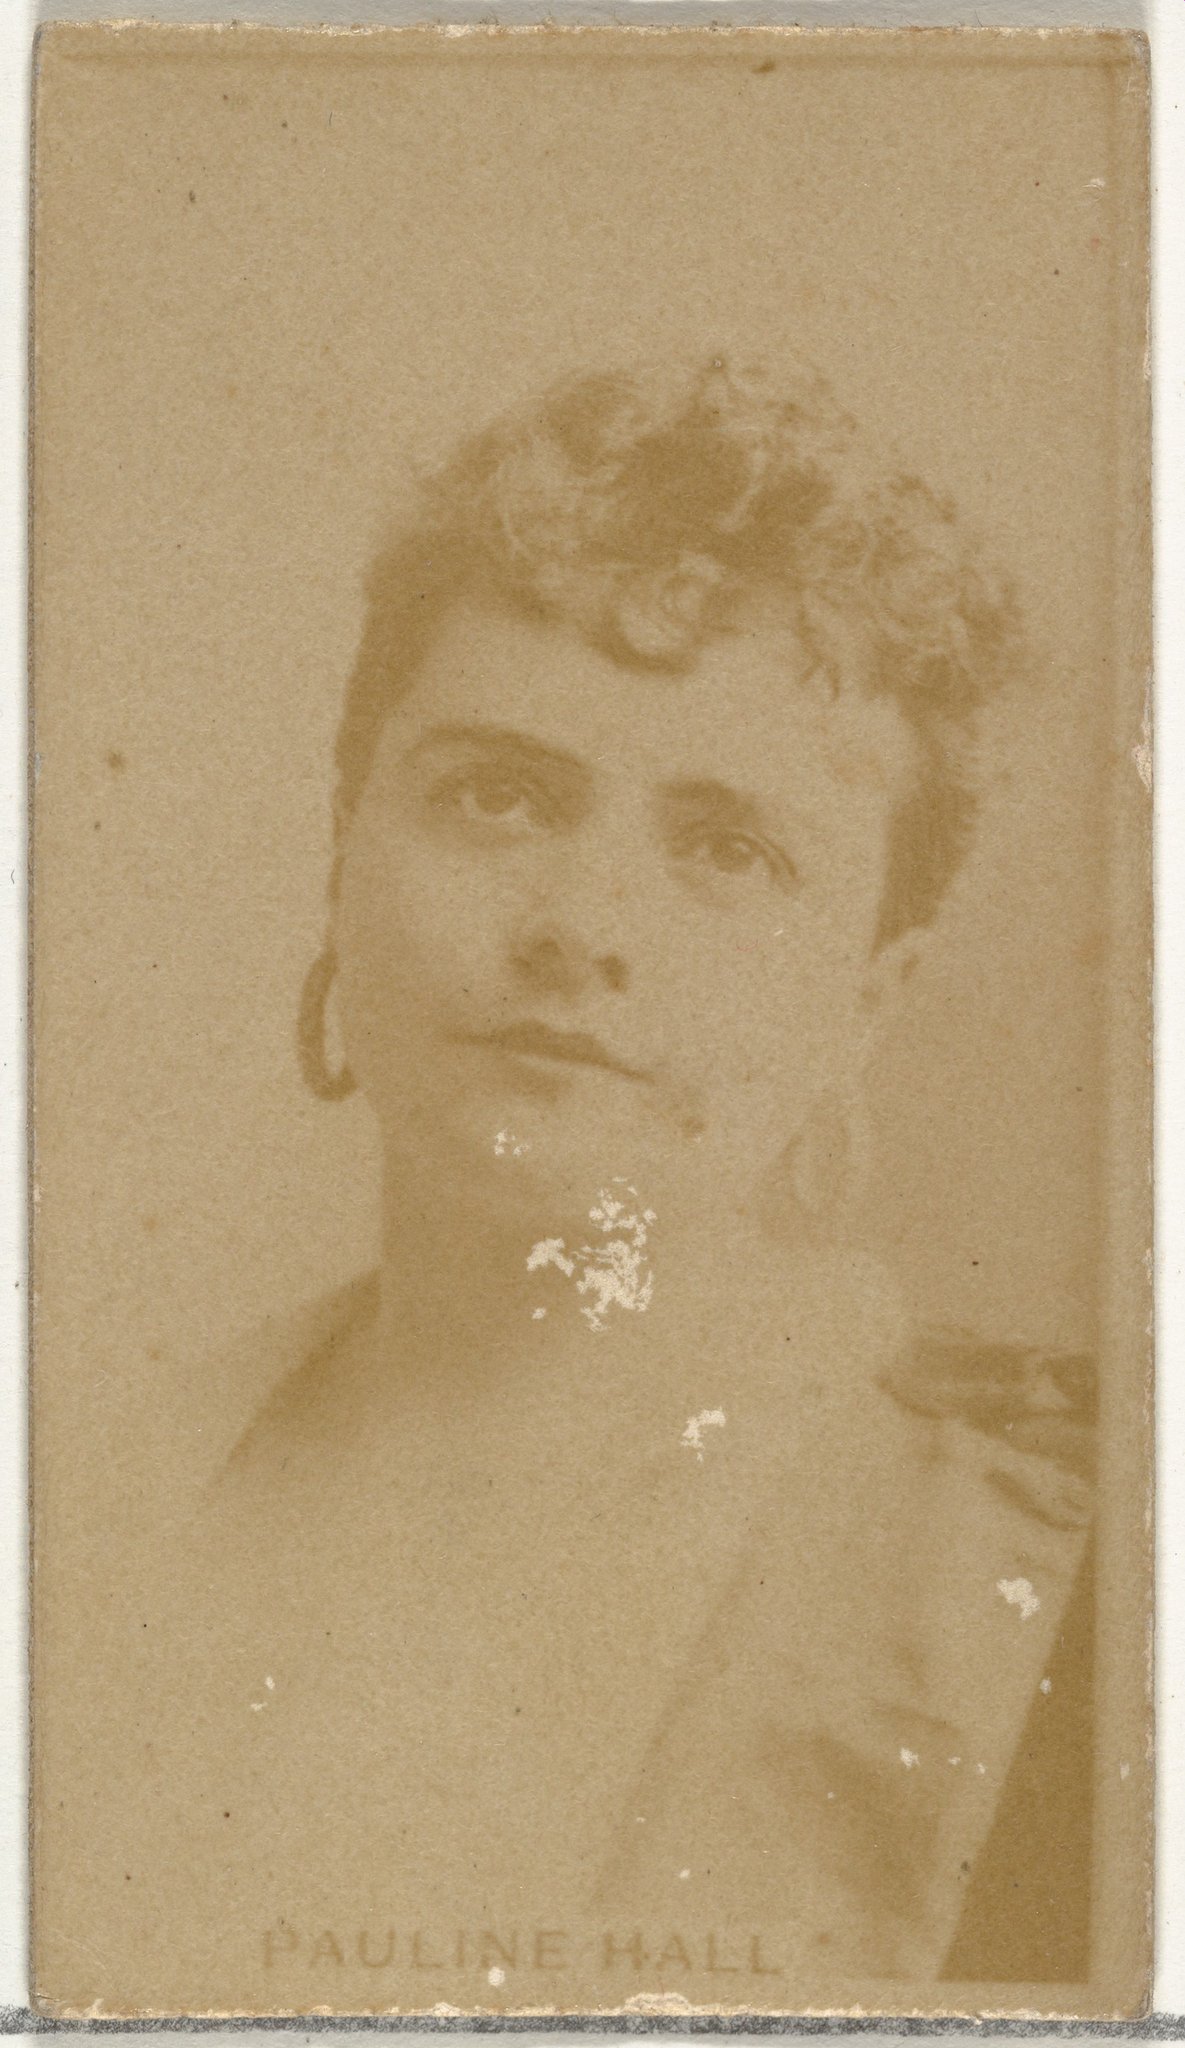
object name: photograph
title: Pauline Hall, from the Actors and Actresses series (N145-8) issued by Duke Sons & Co. to promote Duke Cigarettes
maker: w. duke, sons & co.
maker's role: publisher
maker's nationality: american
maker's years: 1870-1920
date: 1891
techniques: albumen silver print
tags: portraits,women,actresses